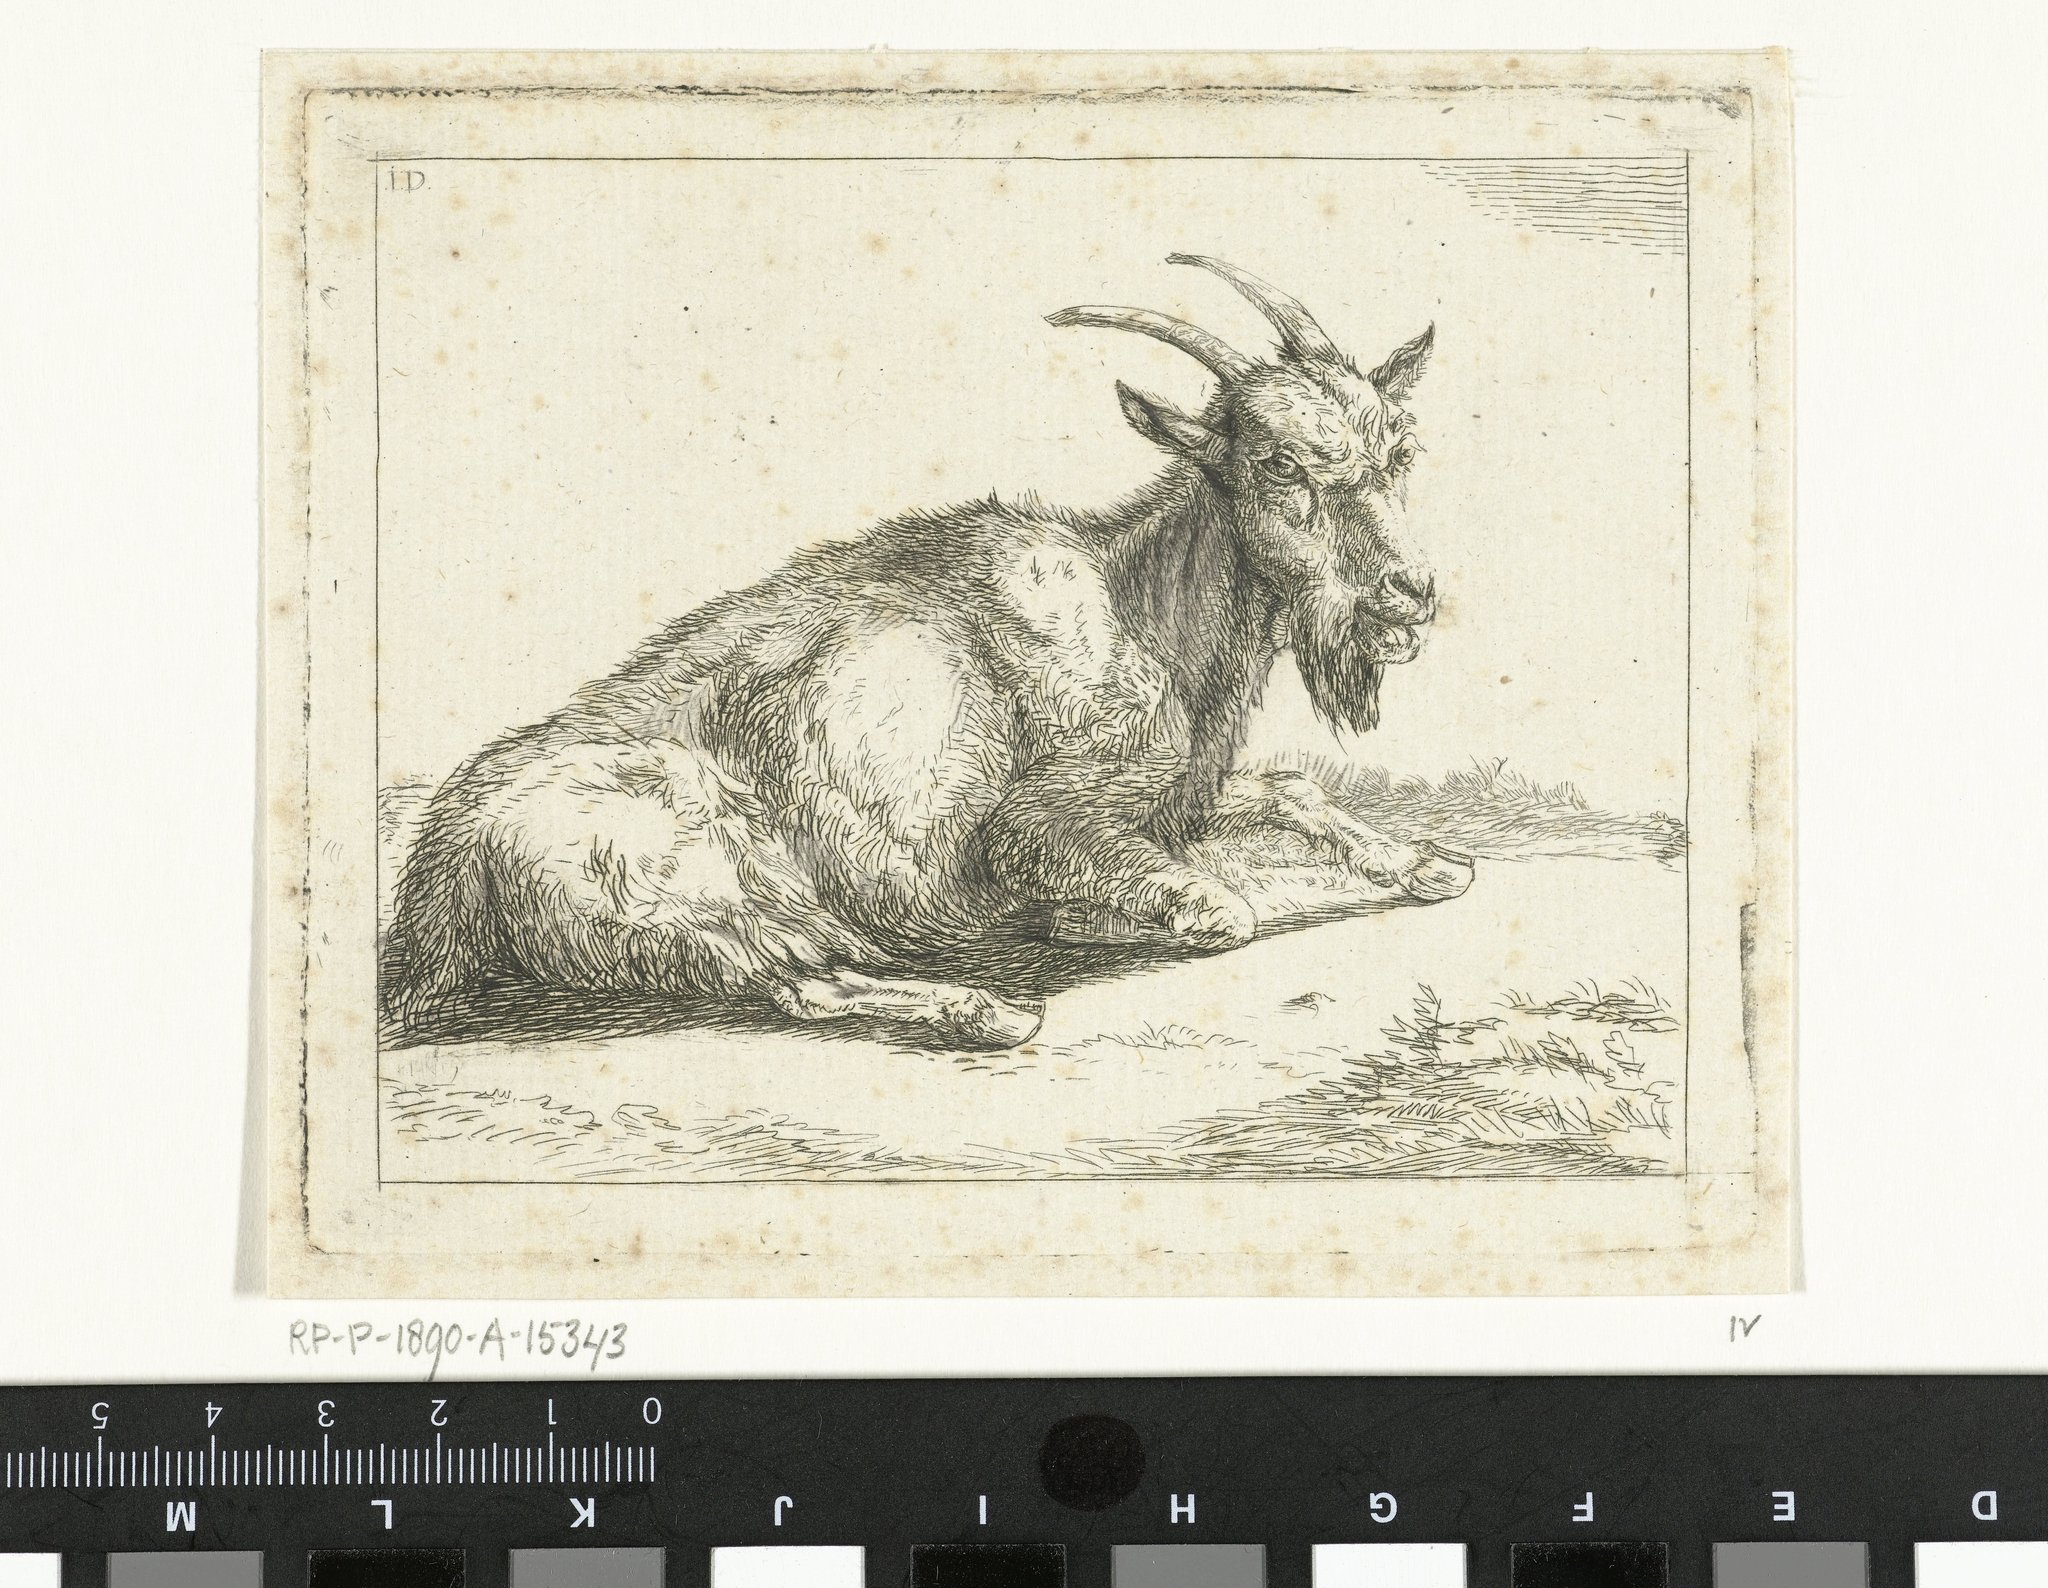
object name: print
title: Geit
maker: jan dasveldt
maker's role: draughtsman, print maker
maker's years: 1770-1855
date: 1780-1855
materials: chalk, paper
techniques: etching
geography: amsterdam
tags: goat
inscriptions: collector's mark: Lugt 2228